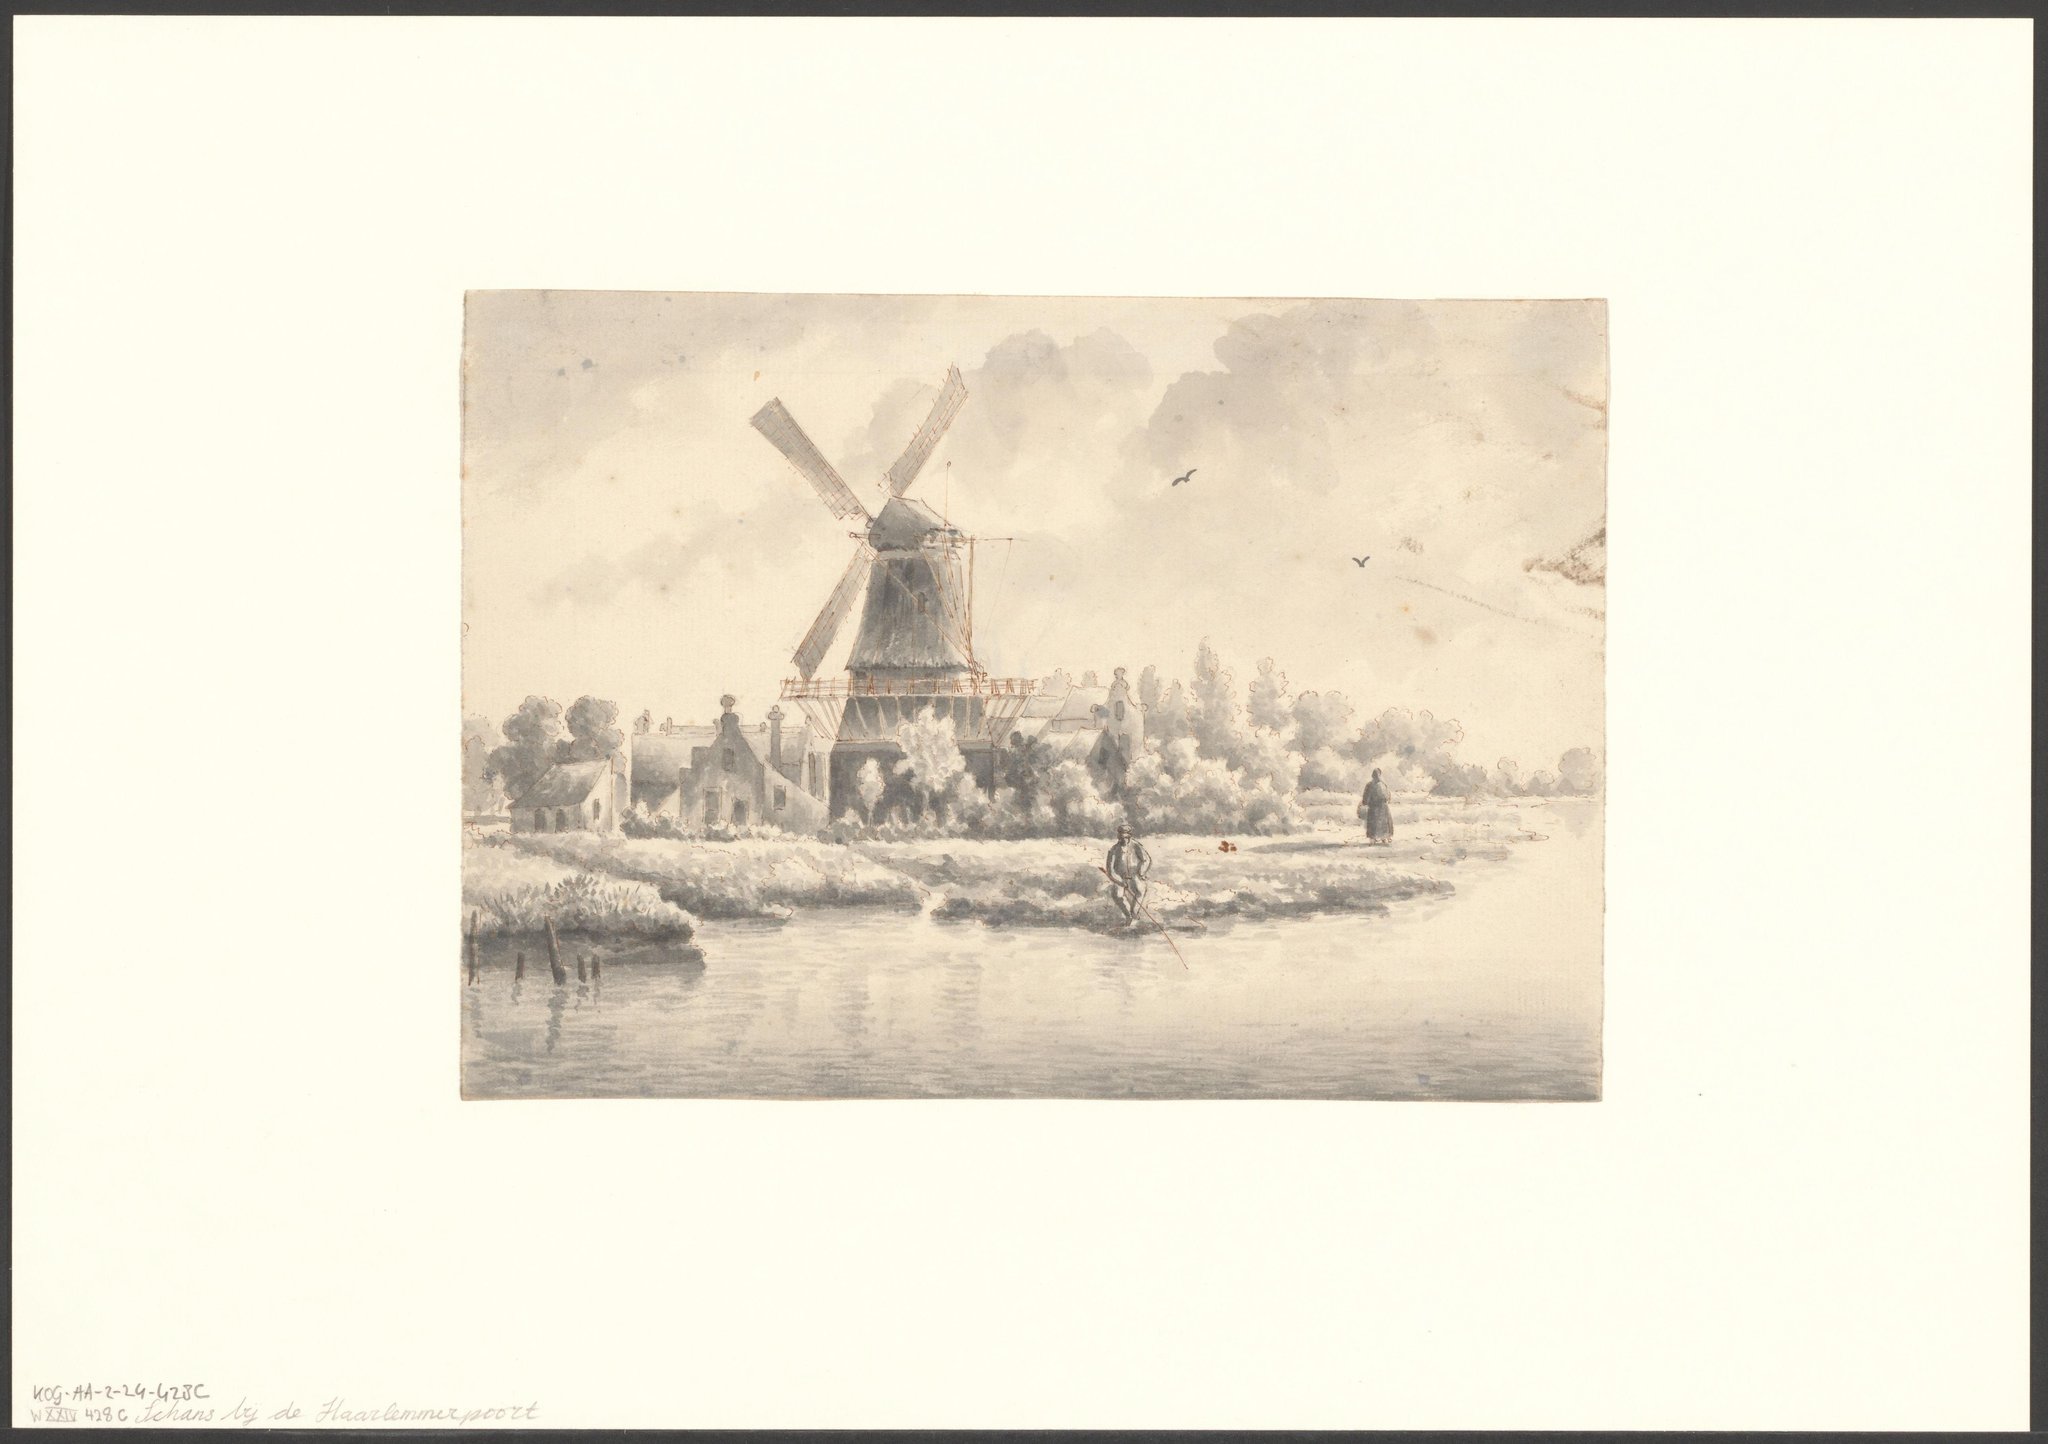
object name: drawing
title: Gezicht op bolwerk Sloterdijk met molen de Kraay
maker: Anonymous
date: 1750-1850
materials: ink, paper, pencil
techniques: brush, pen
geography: amsterdam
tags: city-view in general; 'veduta', canal, windmill in landscape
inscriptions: initials: ‘EDPz’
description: Tekening binnen de Atlas Van Eck ingedeeld op wijknummer 24.